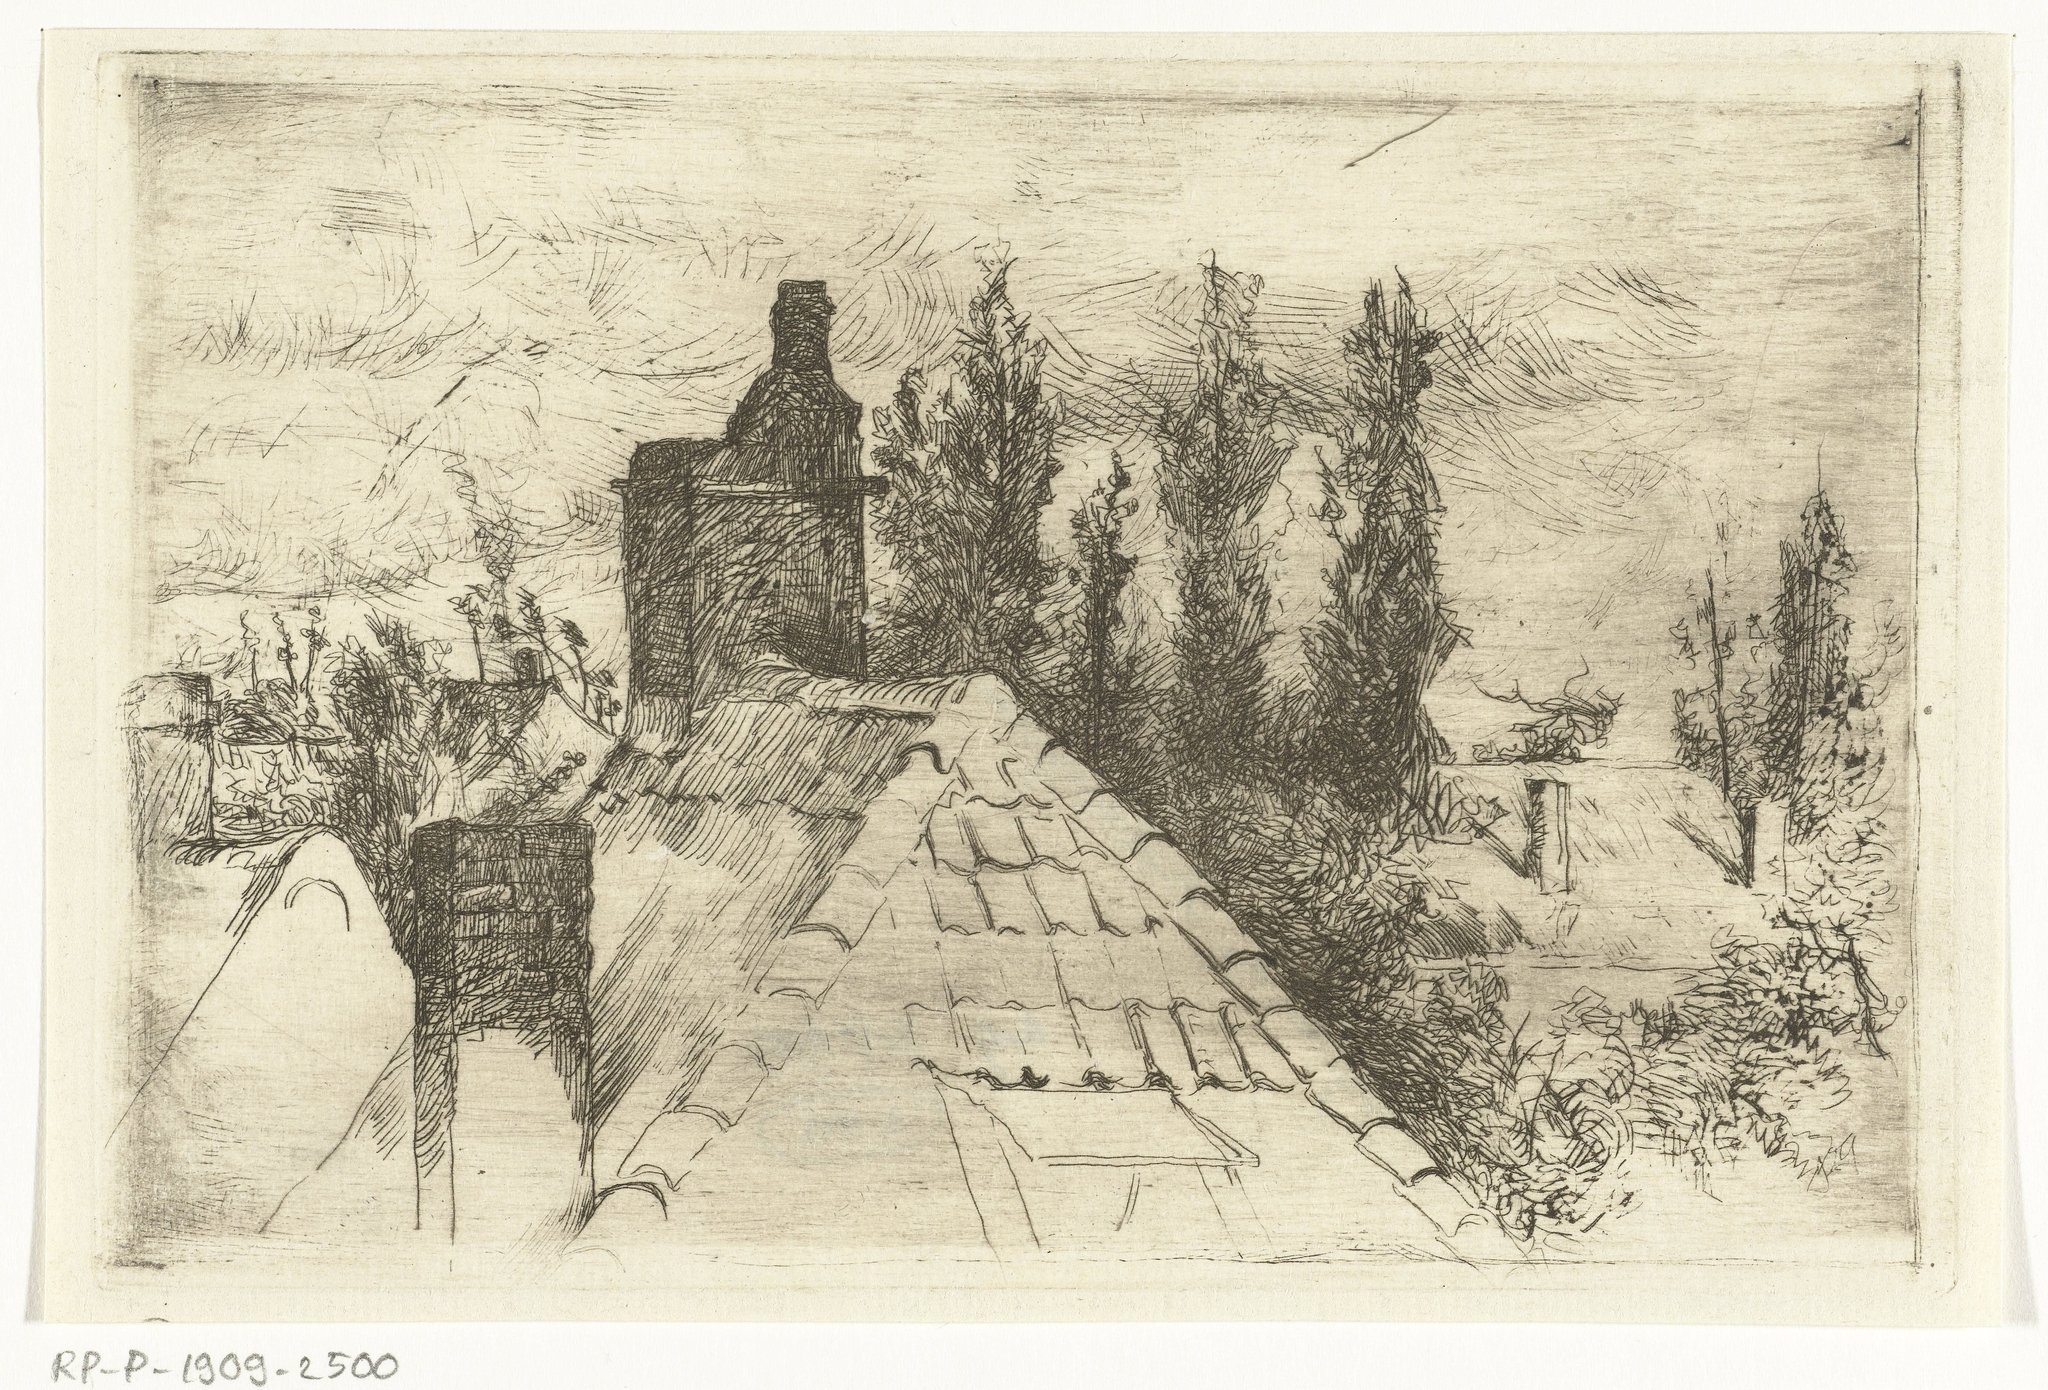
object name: print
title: Gezicht in Antwerpen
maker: gerard jan bos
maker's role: print maker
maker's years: 1860-1943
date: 1878-1885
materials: paper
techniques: drypoint, etching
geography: antwerp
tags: view through a window from the inside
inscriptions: inscription: ‘Gezicht in Antwerpen’, collector's mark: Lugt 2228